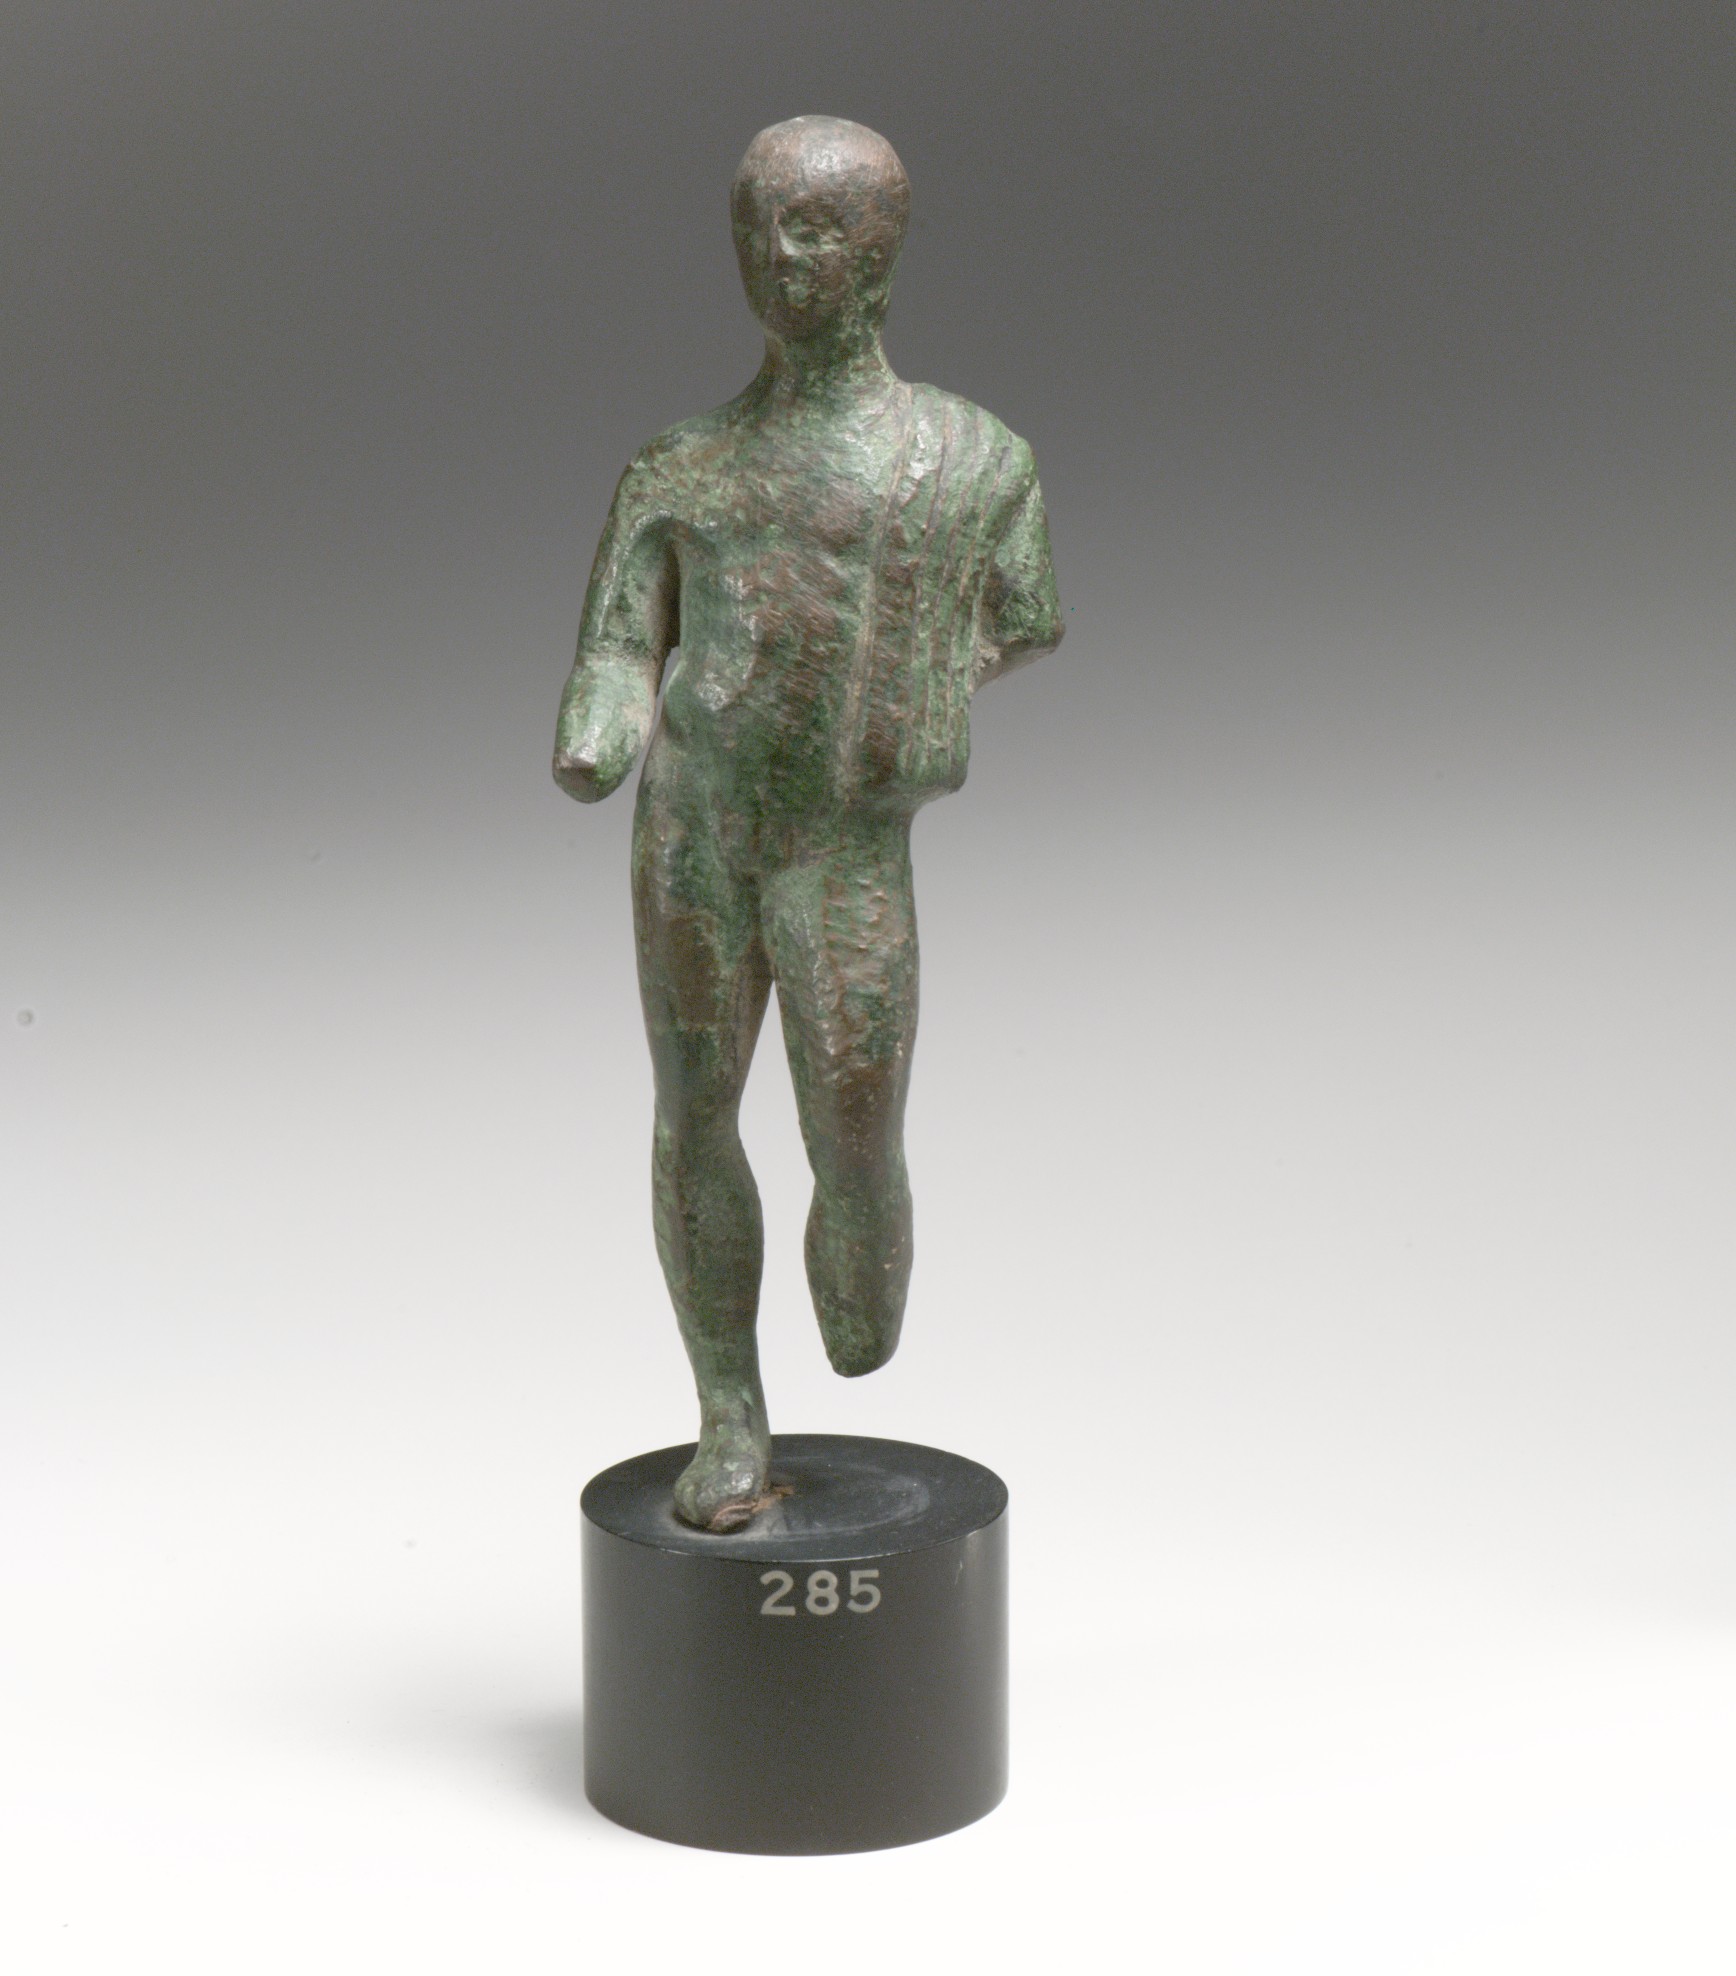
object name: statuette of a youth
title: Bronze statuette of a youth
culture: roman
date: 100 BCE-200 CE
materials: bronze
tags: men